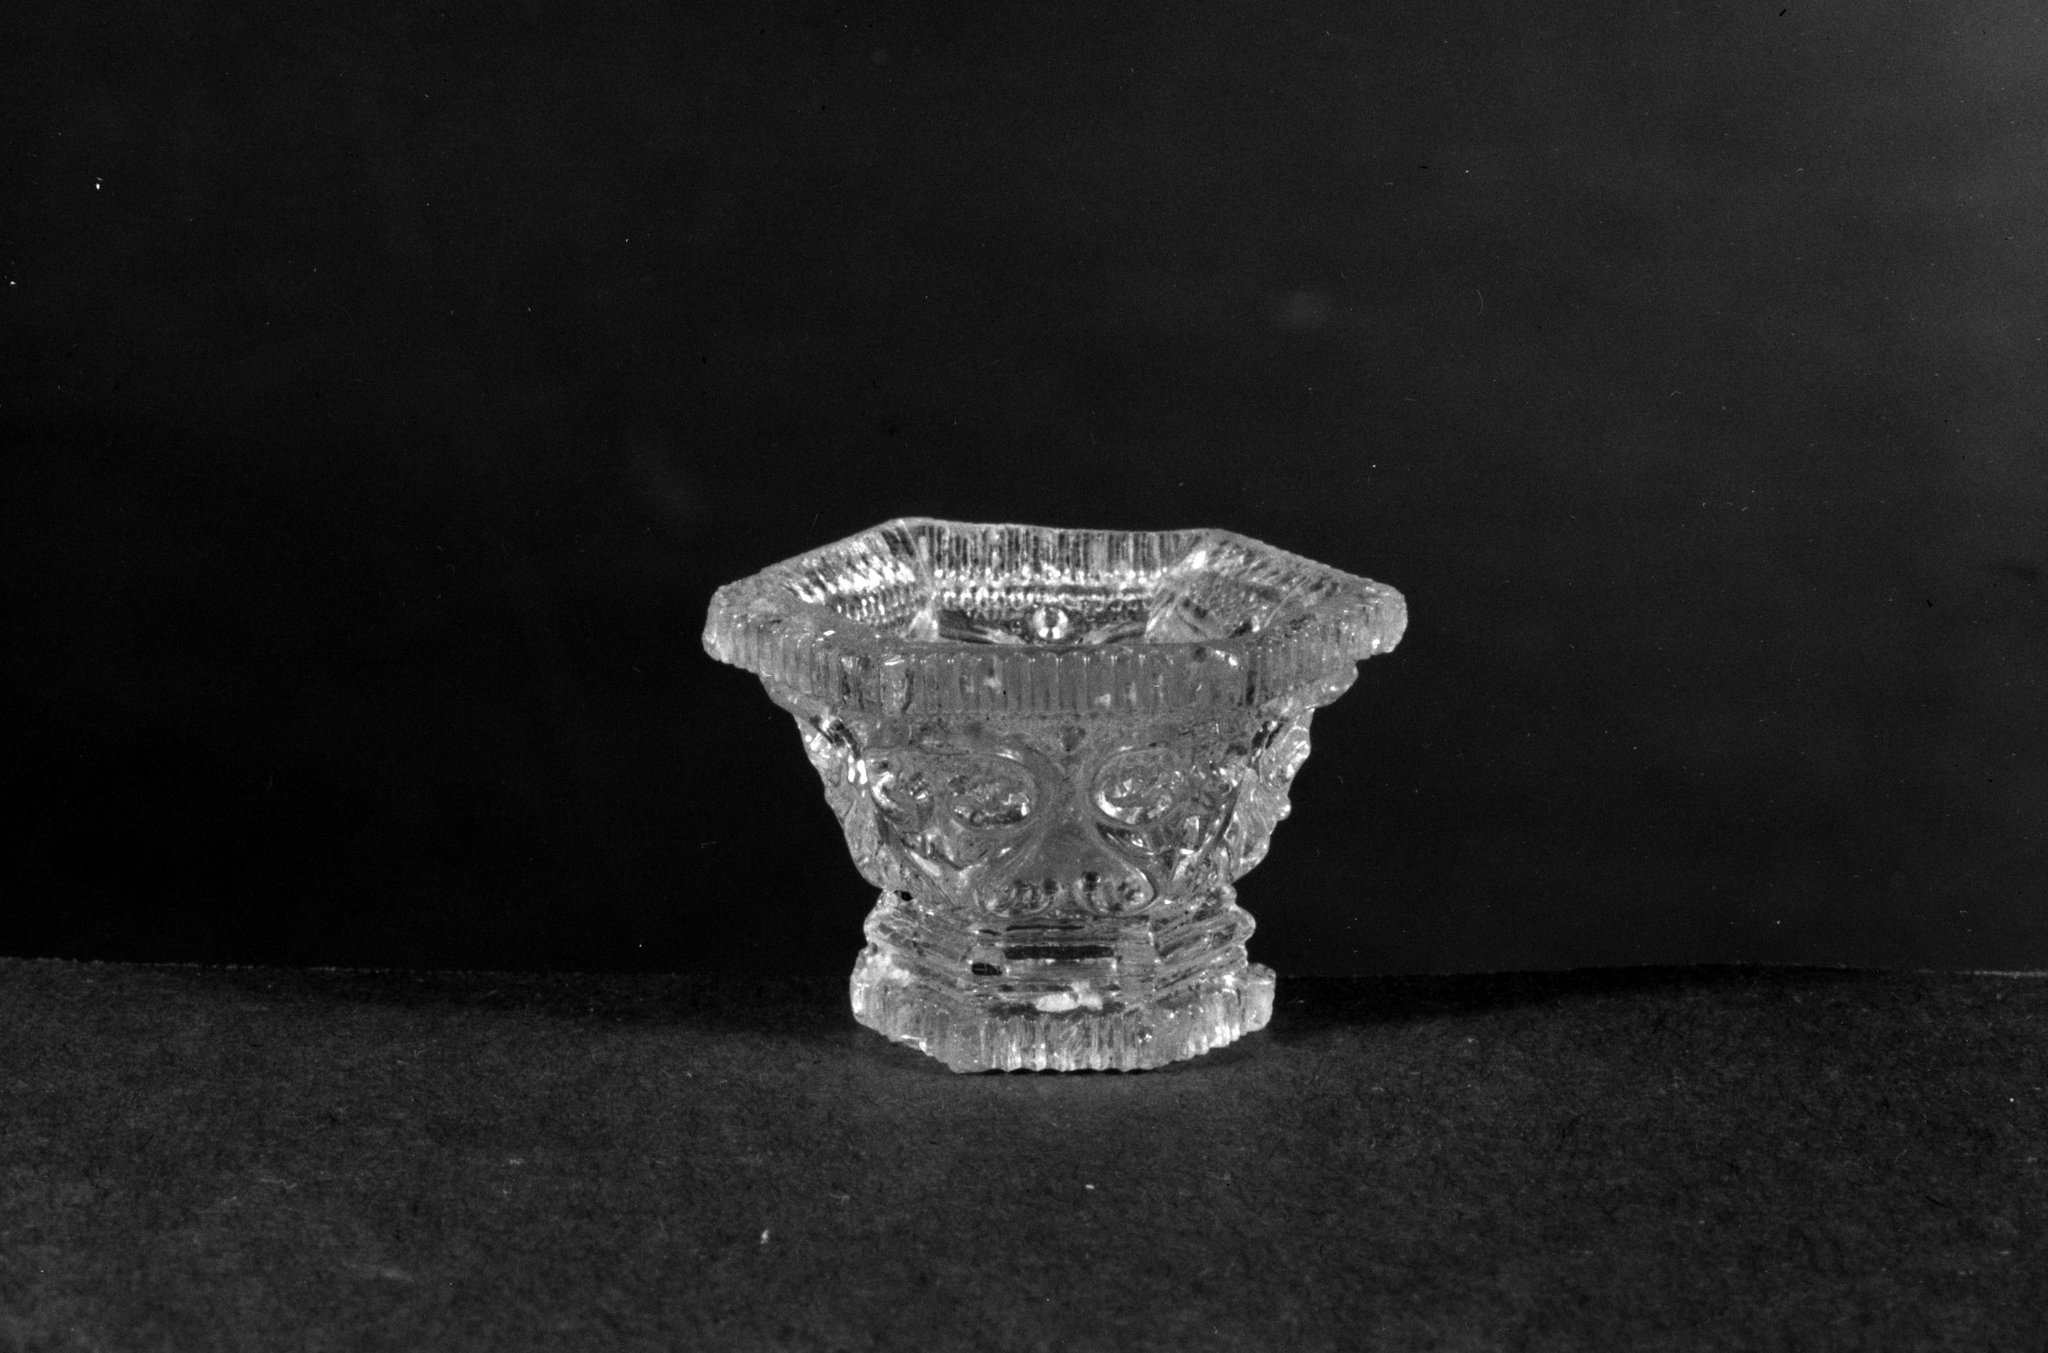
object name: bowl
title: Miniature Bowl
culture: american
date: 1835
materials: glass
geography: united states